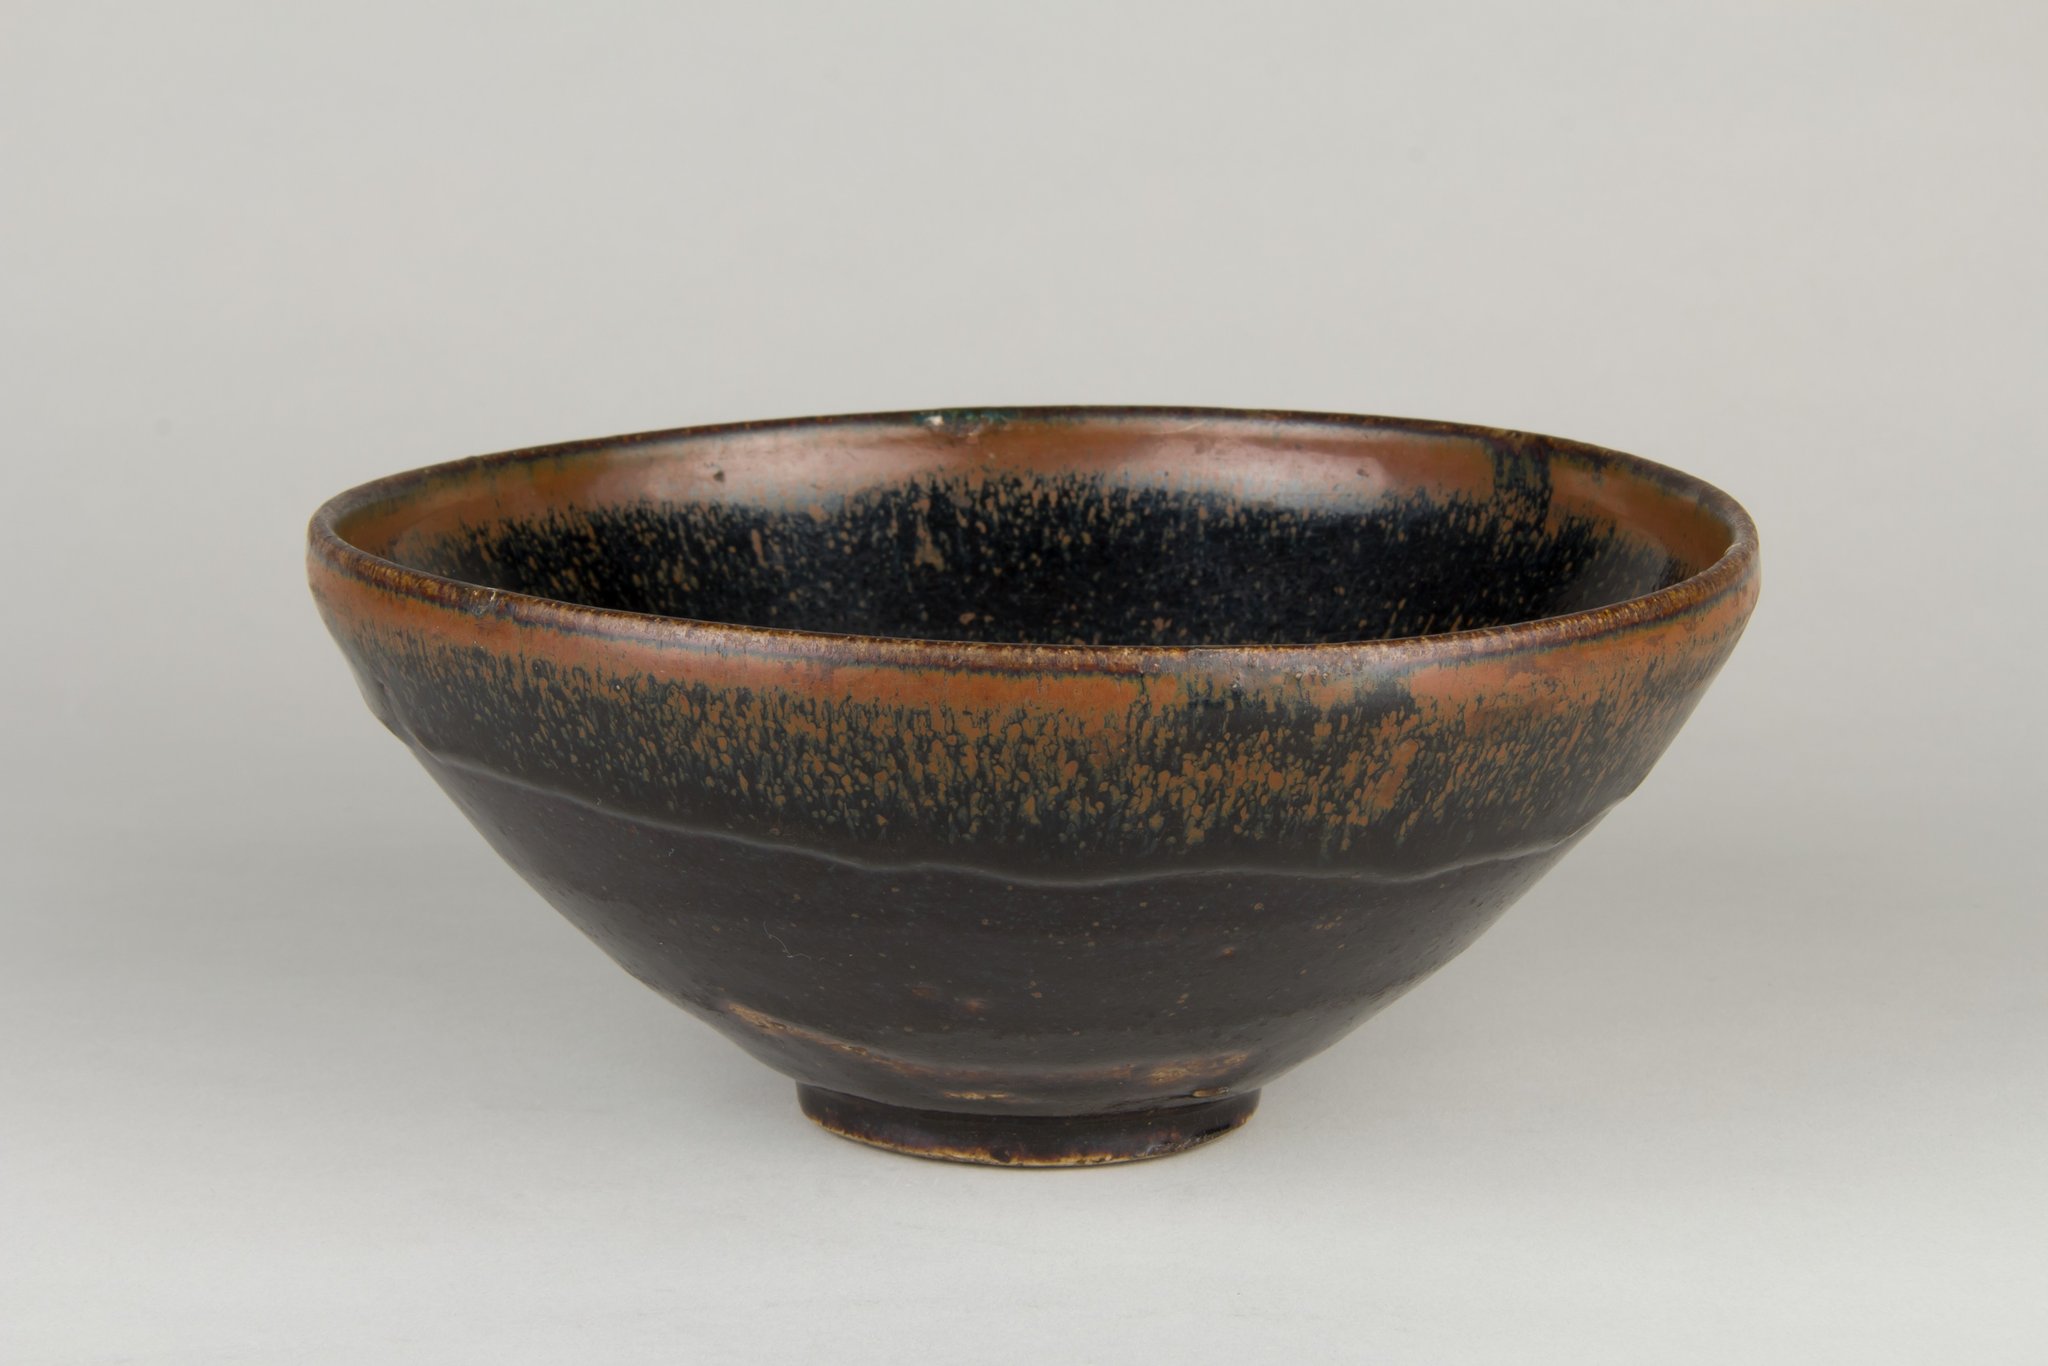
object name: bowl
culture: chinese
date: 960-1279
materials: pottery